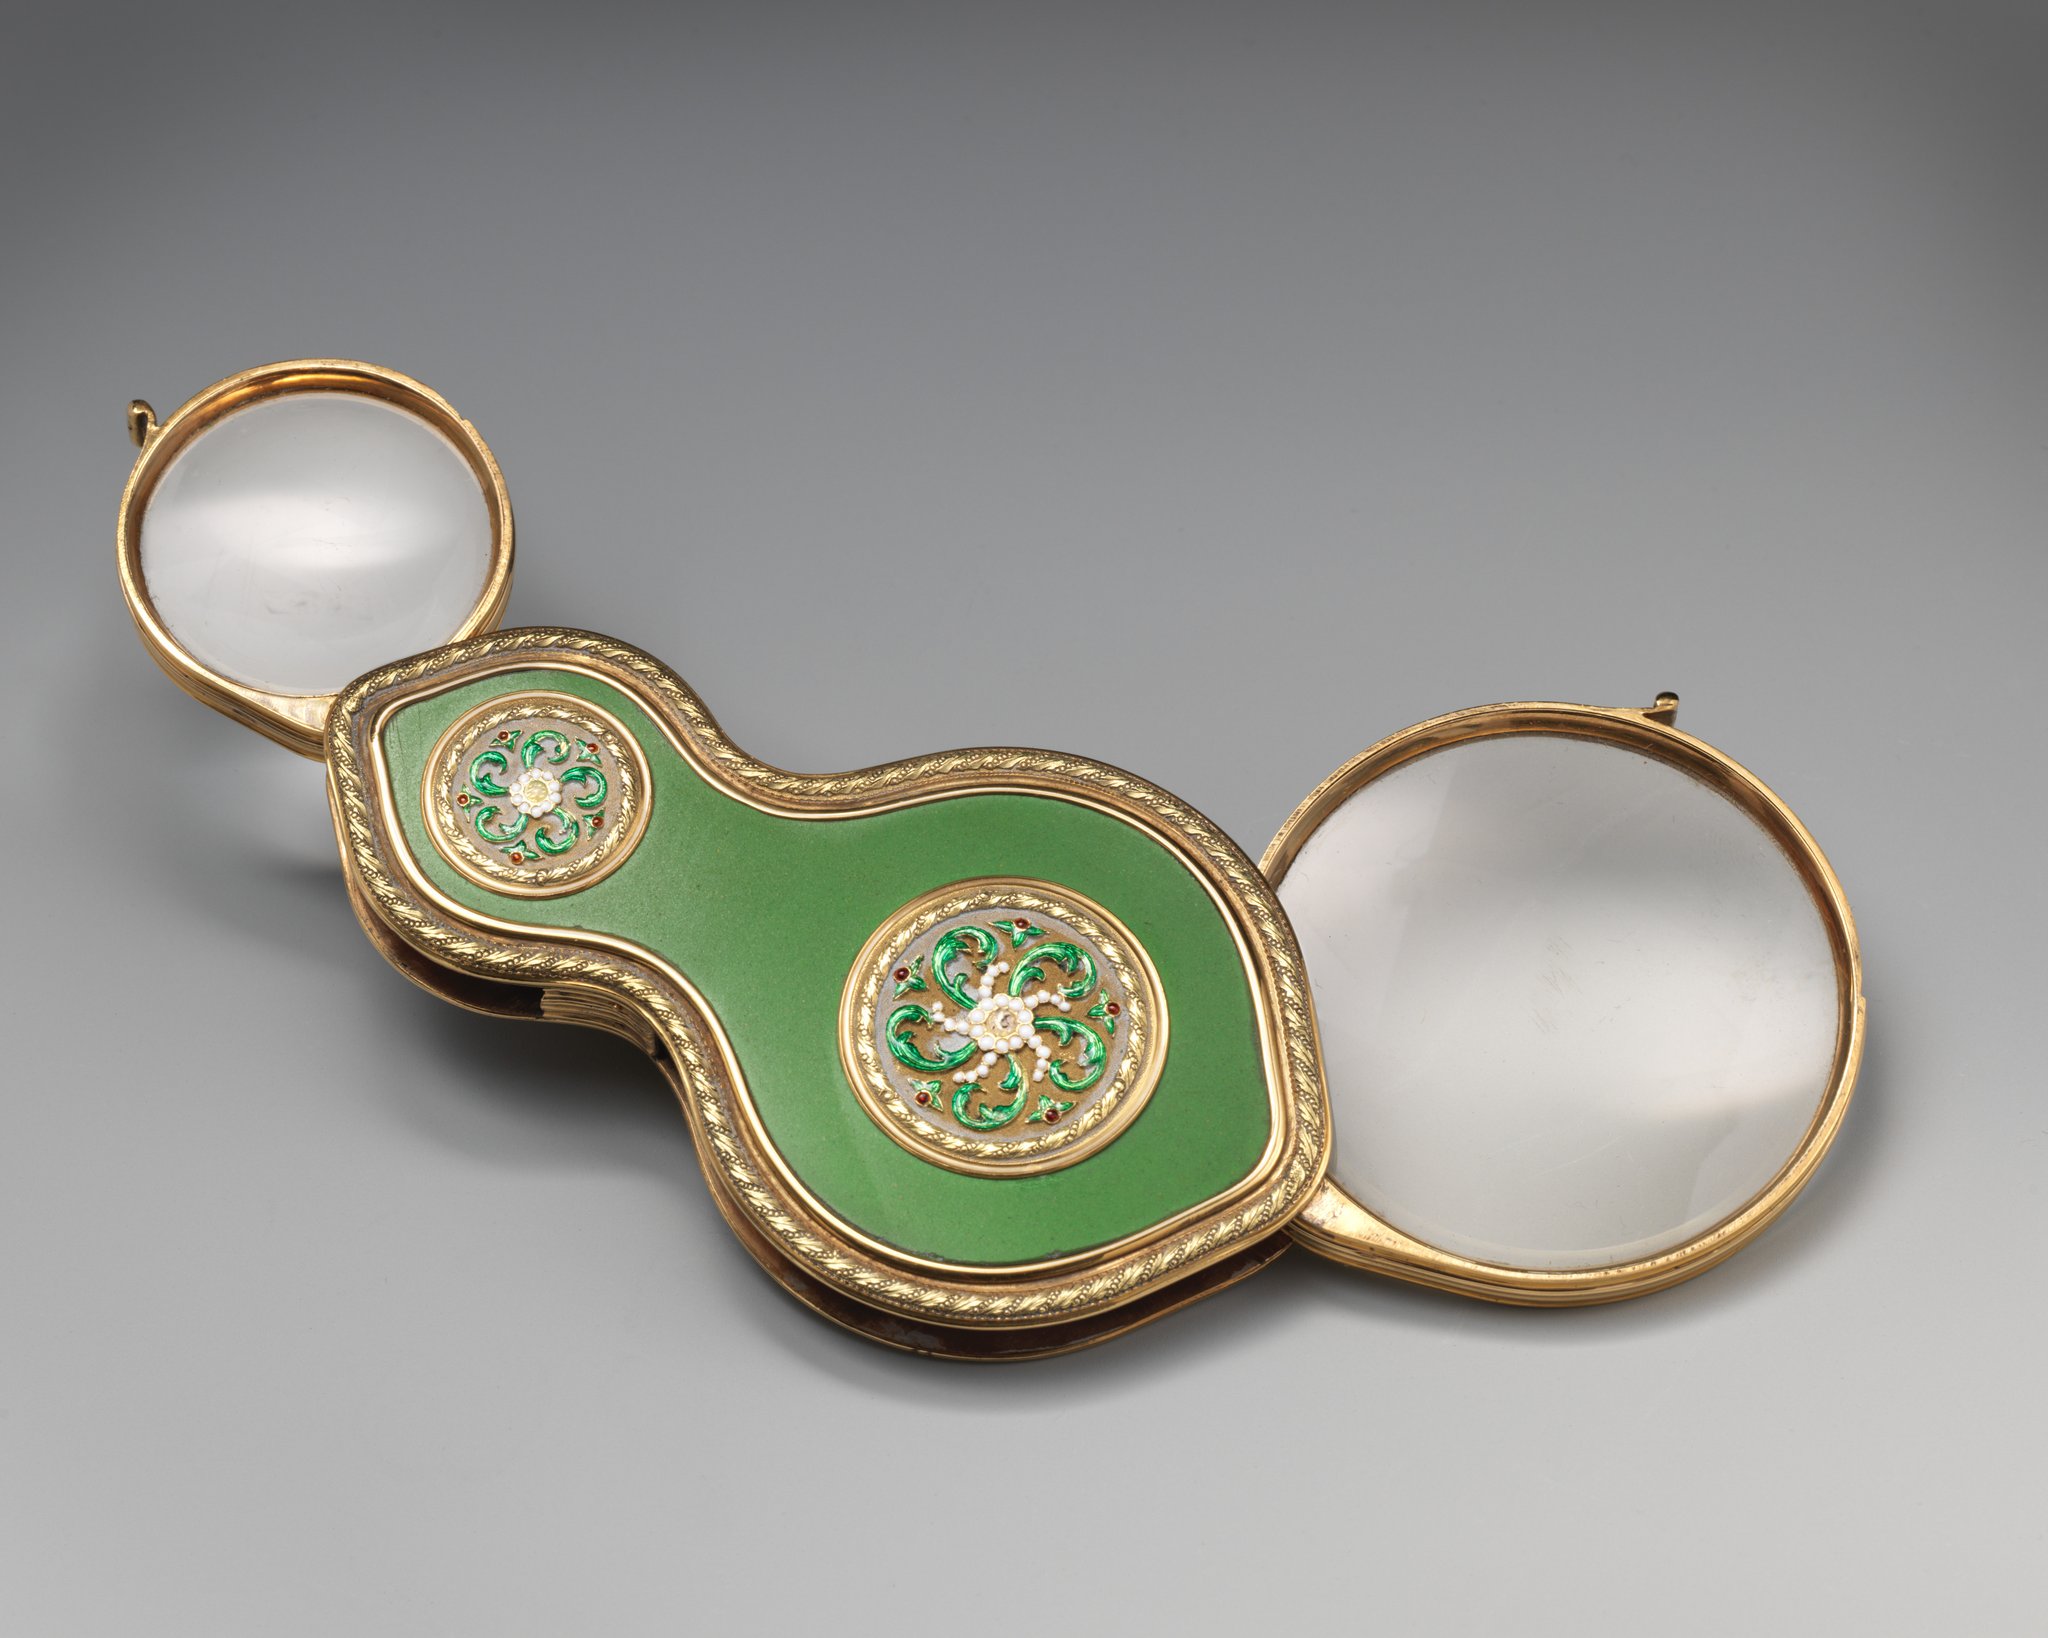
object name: reading glass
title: Reading glass with two lenses (loupe)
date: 1780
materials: enamel, glass, gold